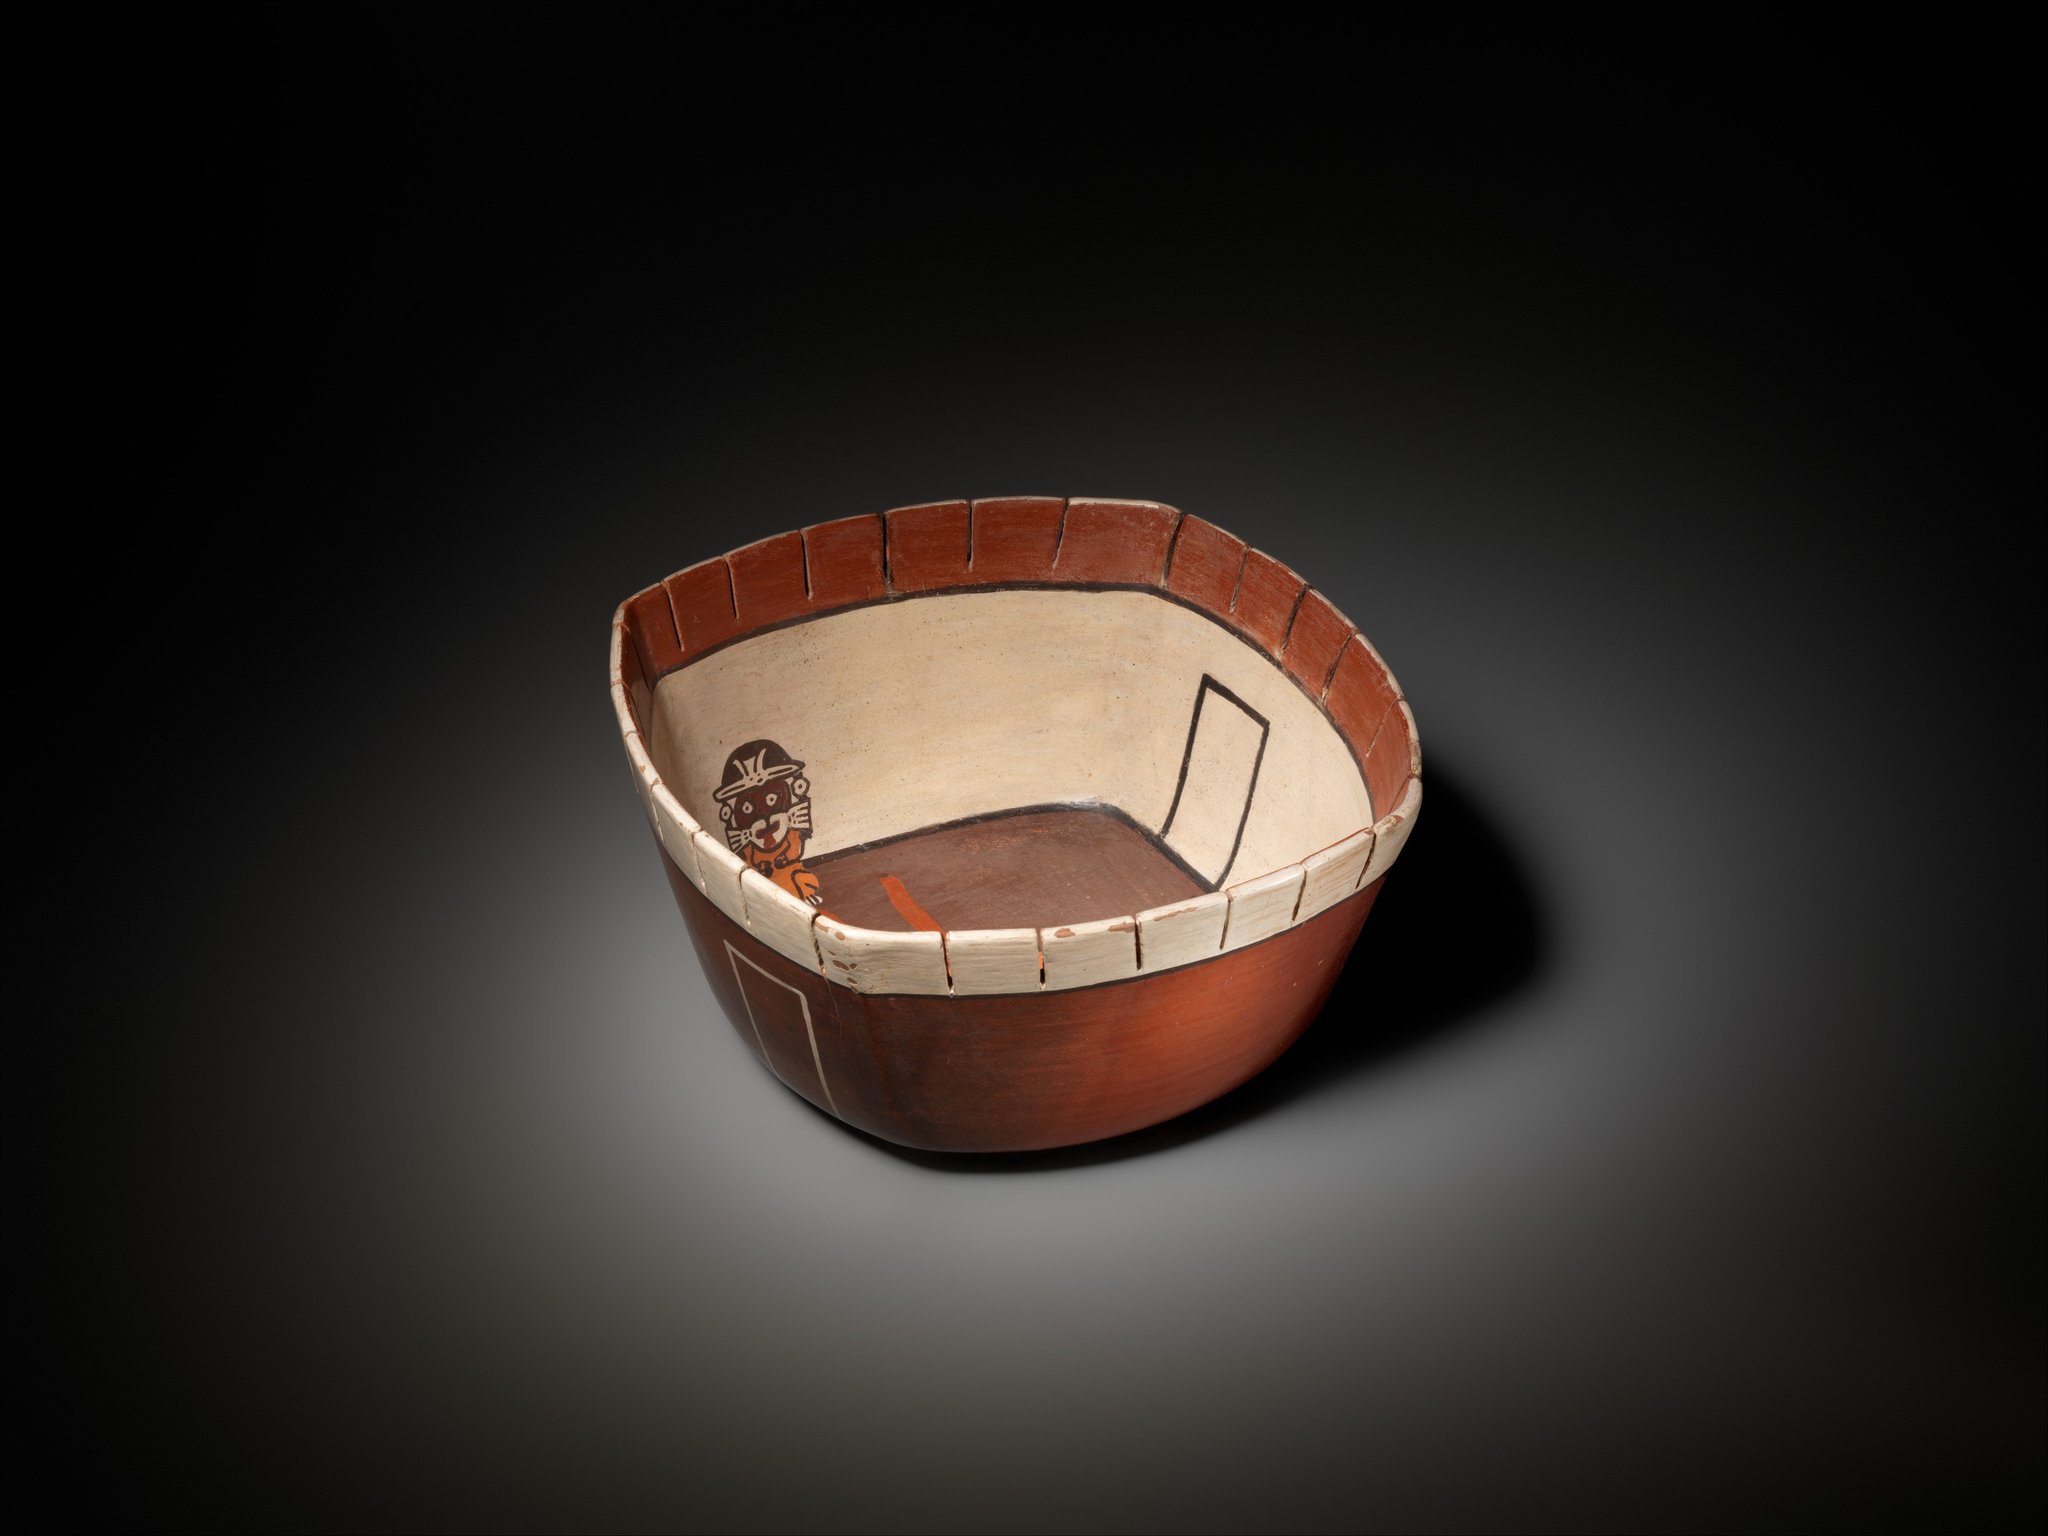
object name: bowl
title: Bowl with a metalworking scene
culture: nasca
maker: nasca artist(s)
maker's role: artist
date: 1-300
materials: ceramic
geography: peru